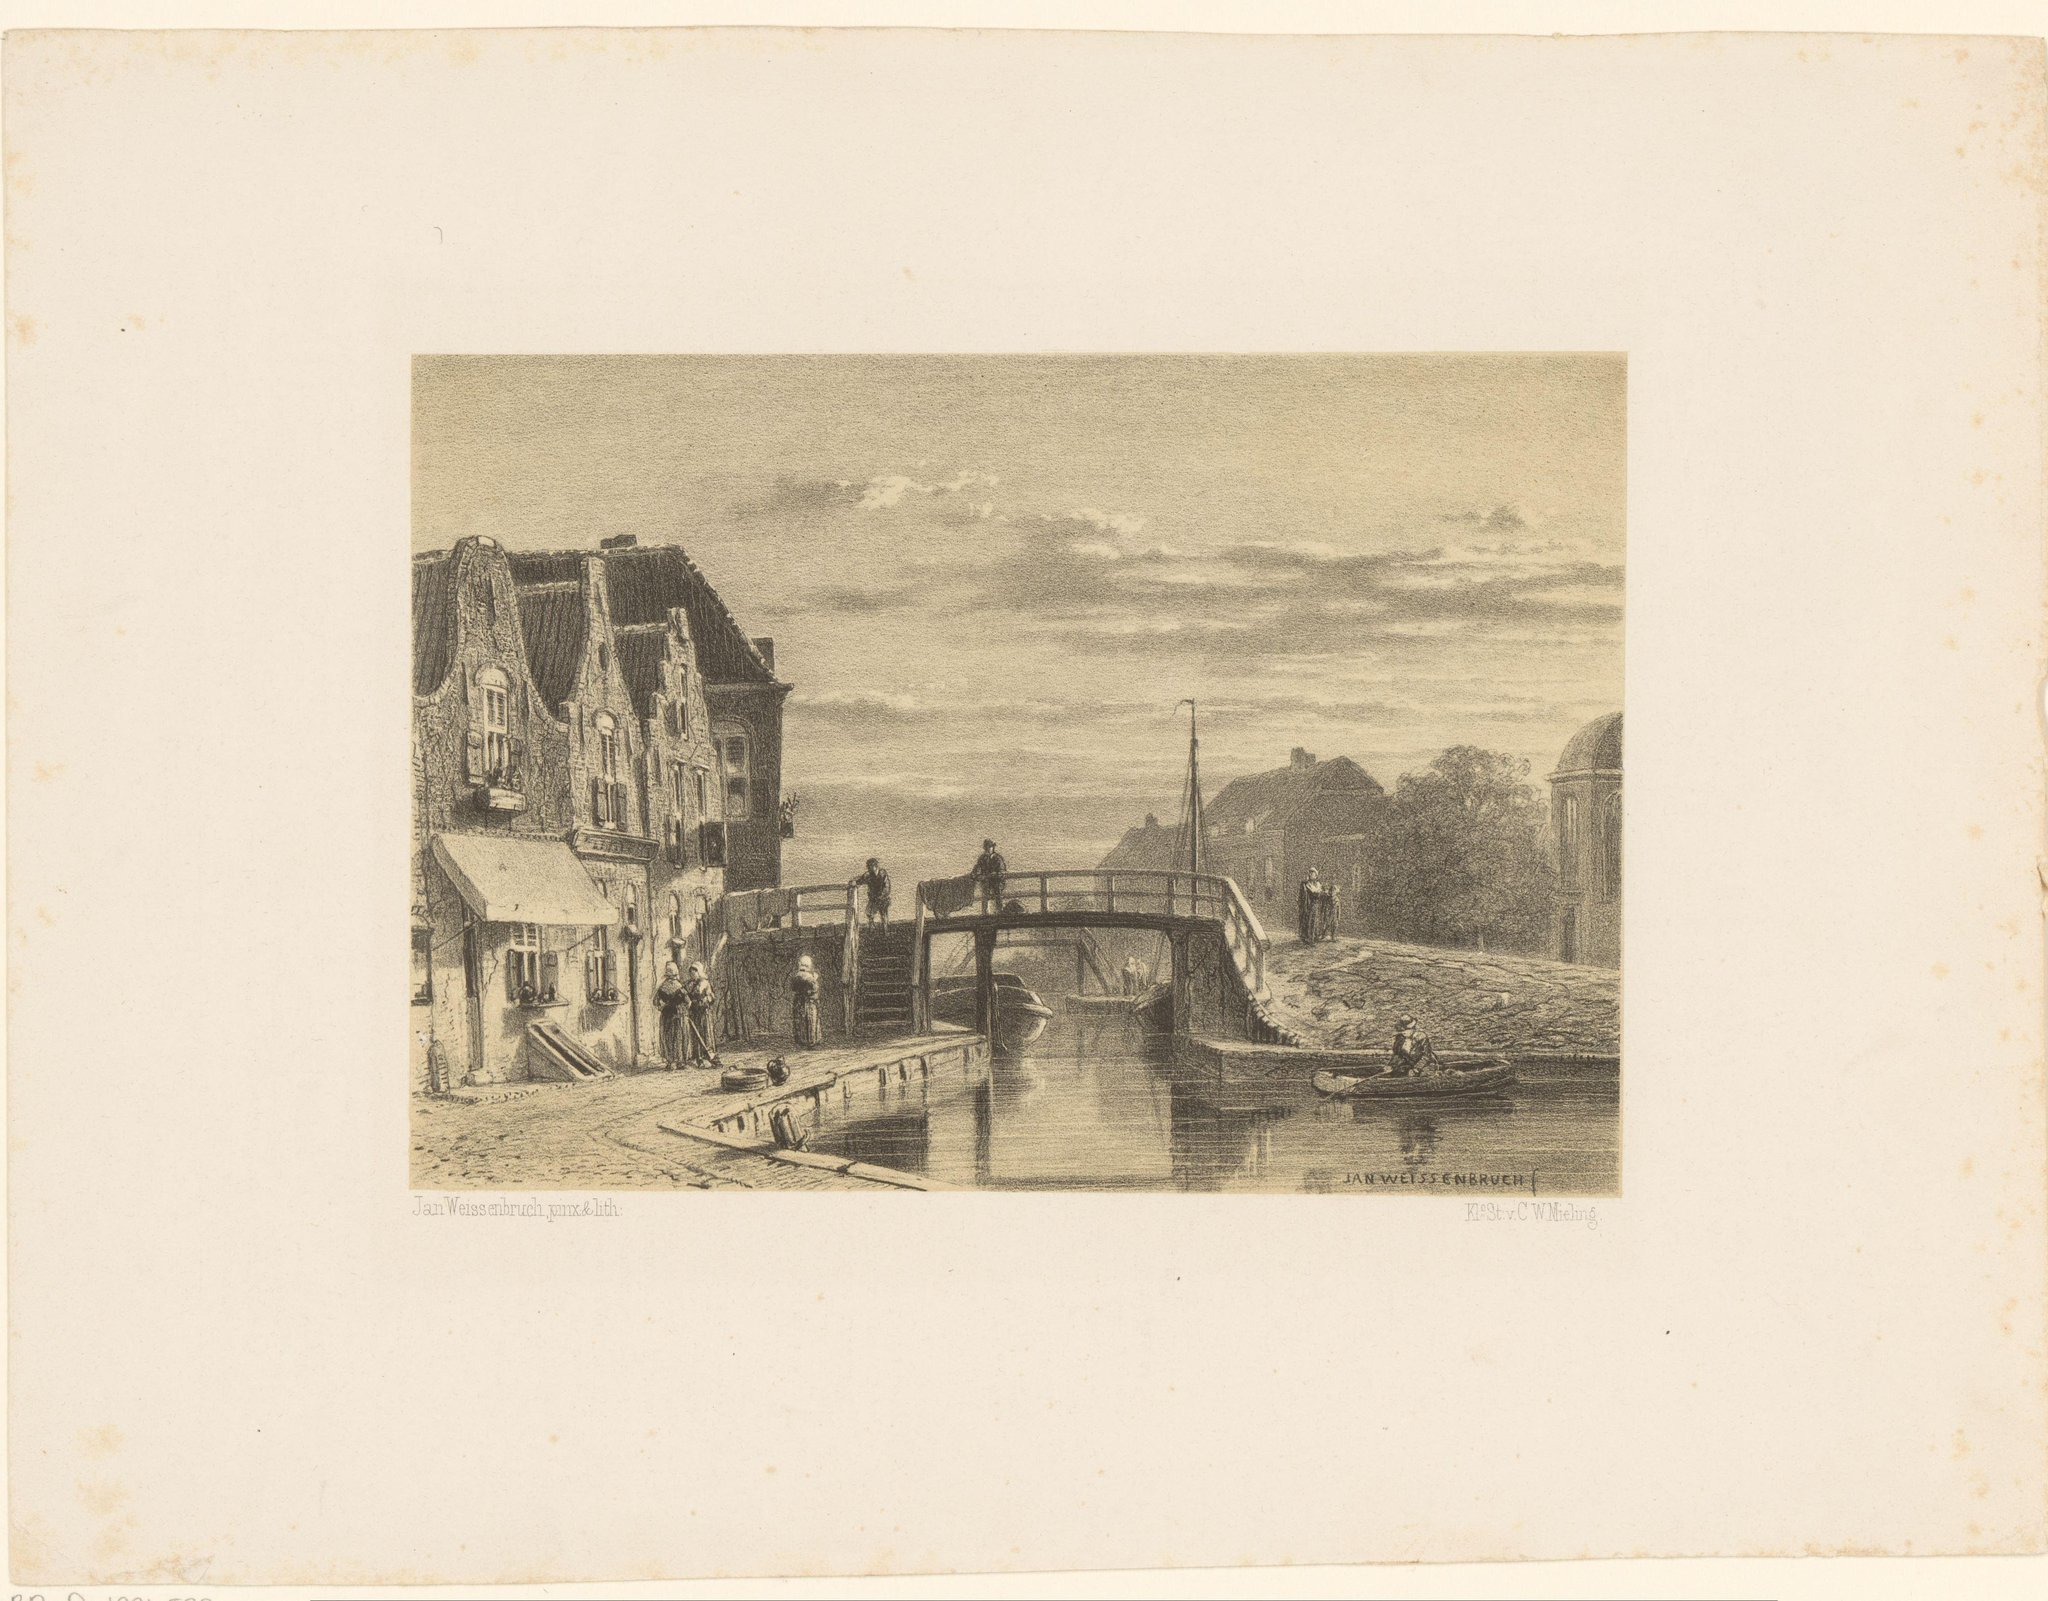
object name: print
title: Stadsgezicht met gracht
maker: jan weissenbruch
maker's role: painter, print maker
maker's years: 1822-1880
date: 1847-1865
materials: paper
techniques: tone lithography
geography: the hague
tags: canal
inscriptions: collector's mark: Lugt 2233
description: Op een gracht waarover bruggen lopen, vaart een roeiboot. Links en rechts huizen.